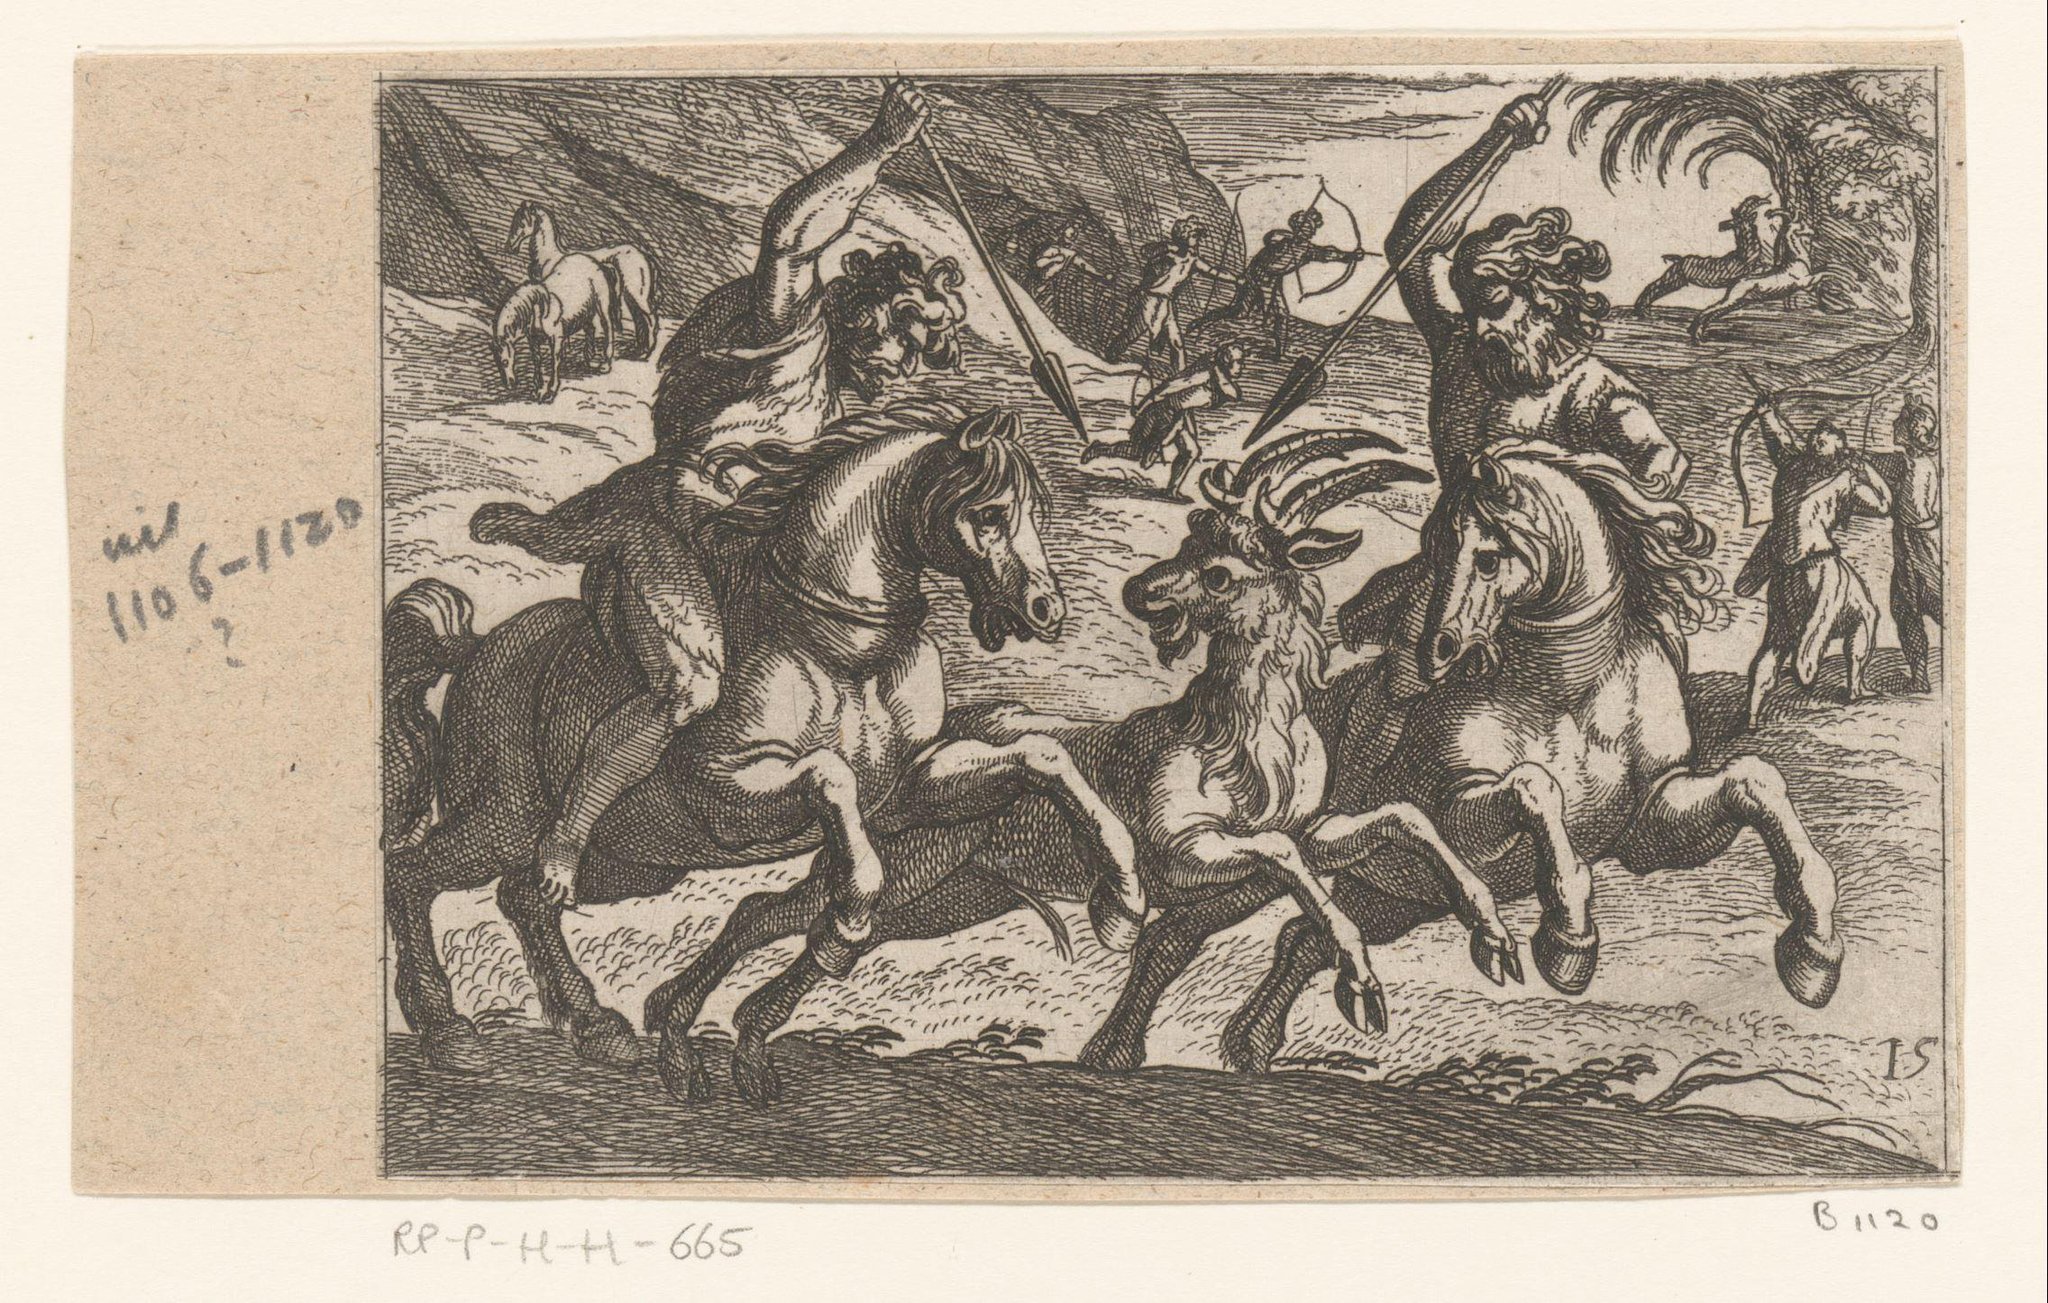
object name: print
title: Jachtscènes (deel 3)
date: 1598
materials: paper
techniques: etching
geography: rome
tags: hunter, hunters hunting (n.b.: in 1988-1990 this notation denoted the concept of 43c11421 'hunters resting during the hunt'), goat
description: Deze prent maakt deel uit van een reeks van vijftien prenten met jachtscènes (+ opdracht).